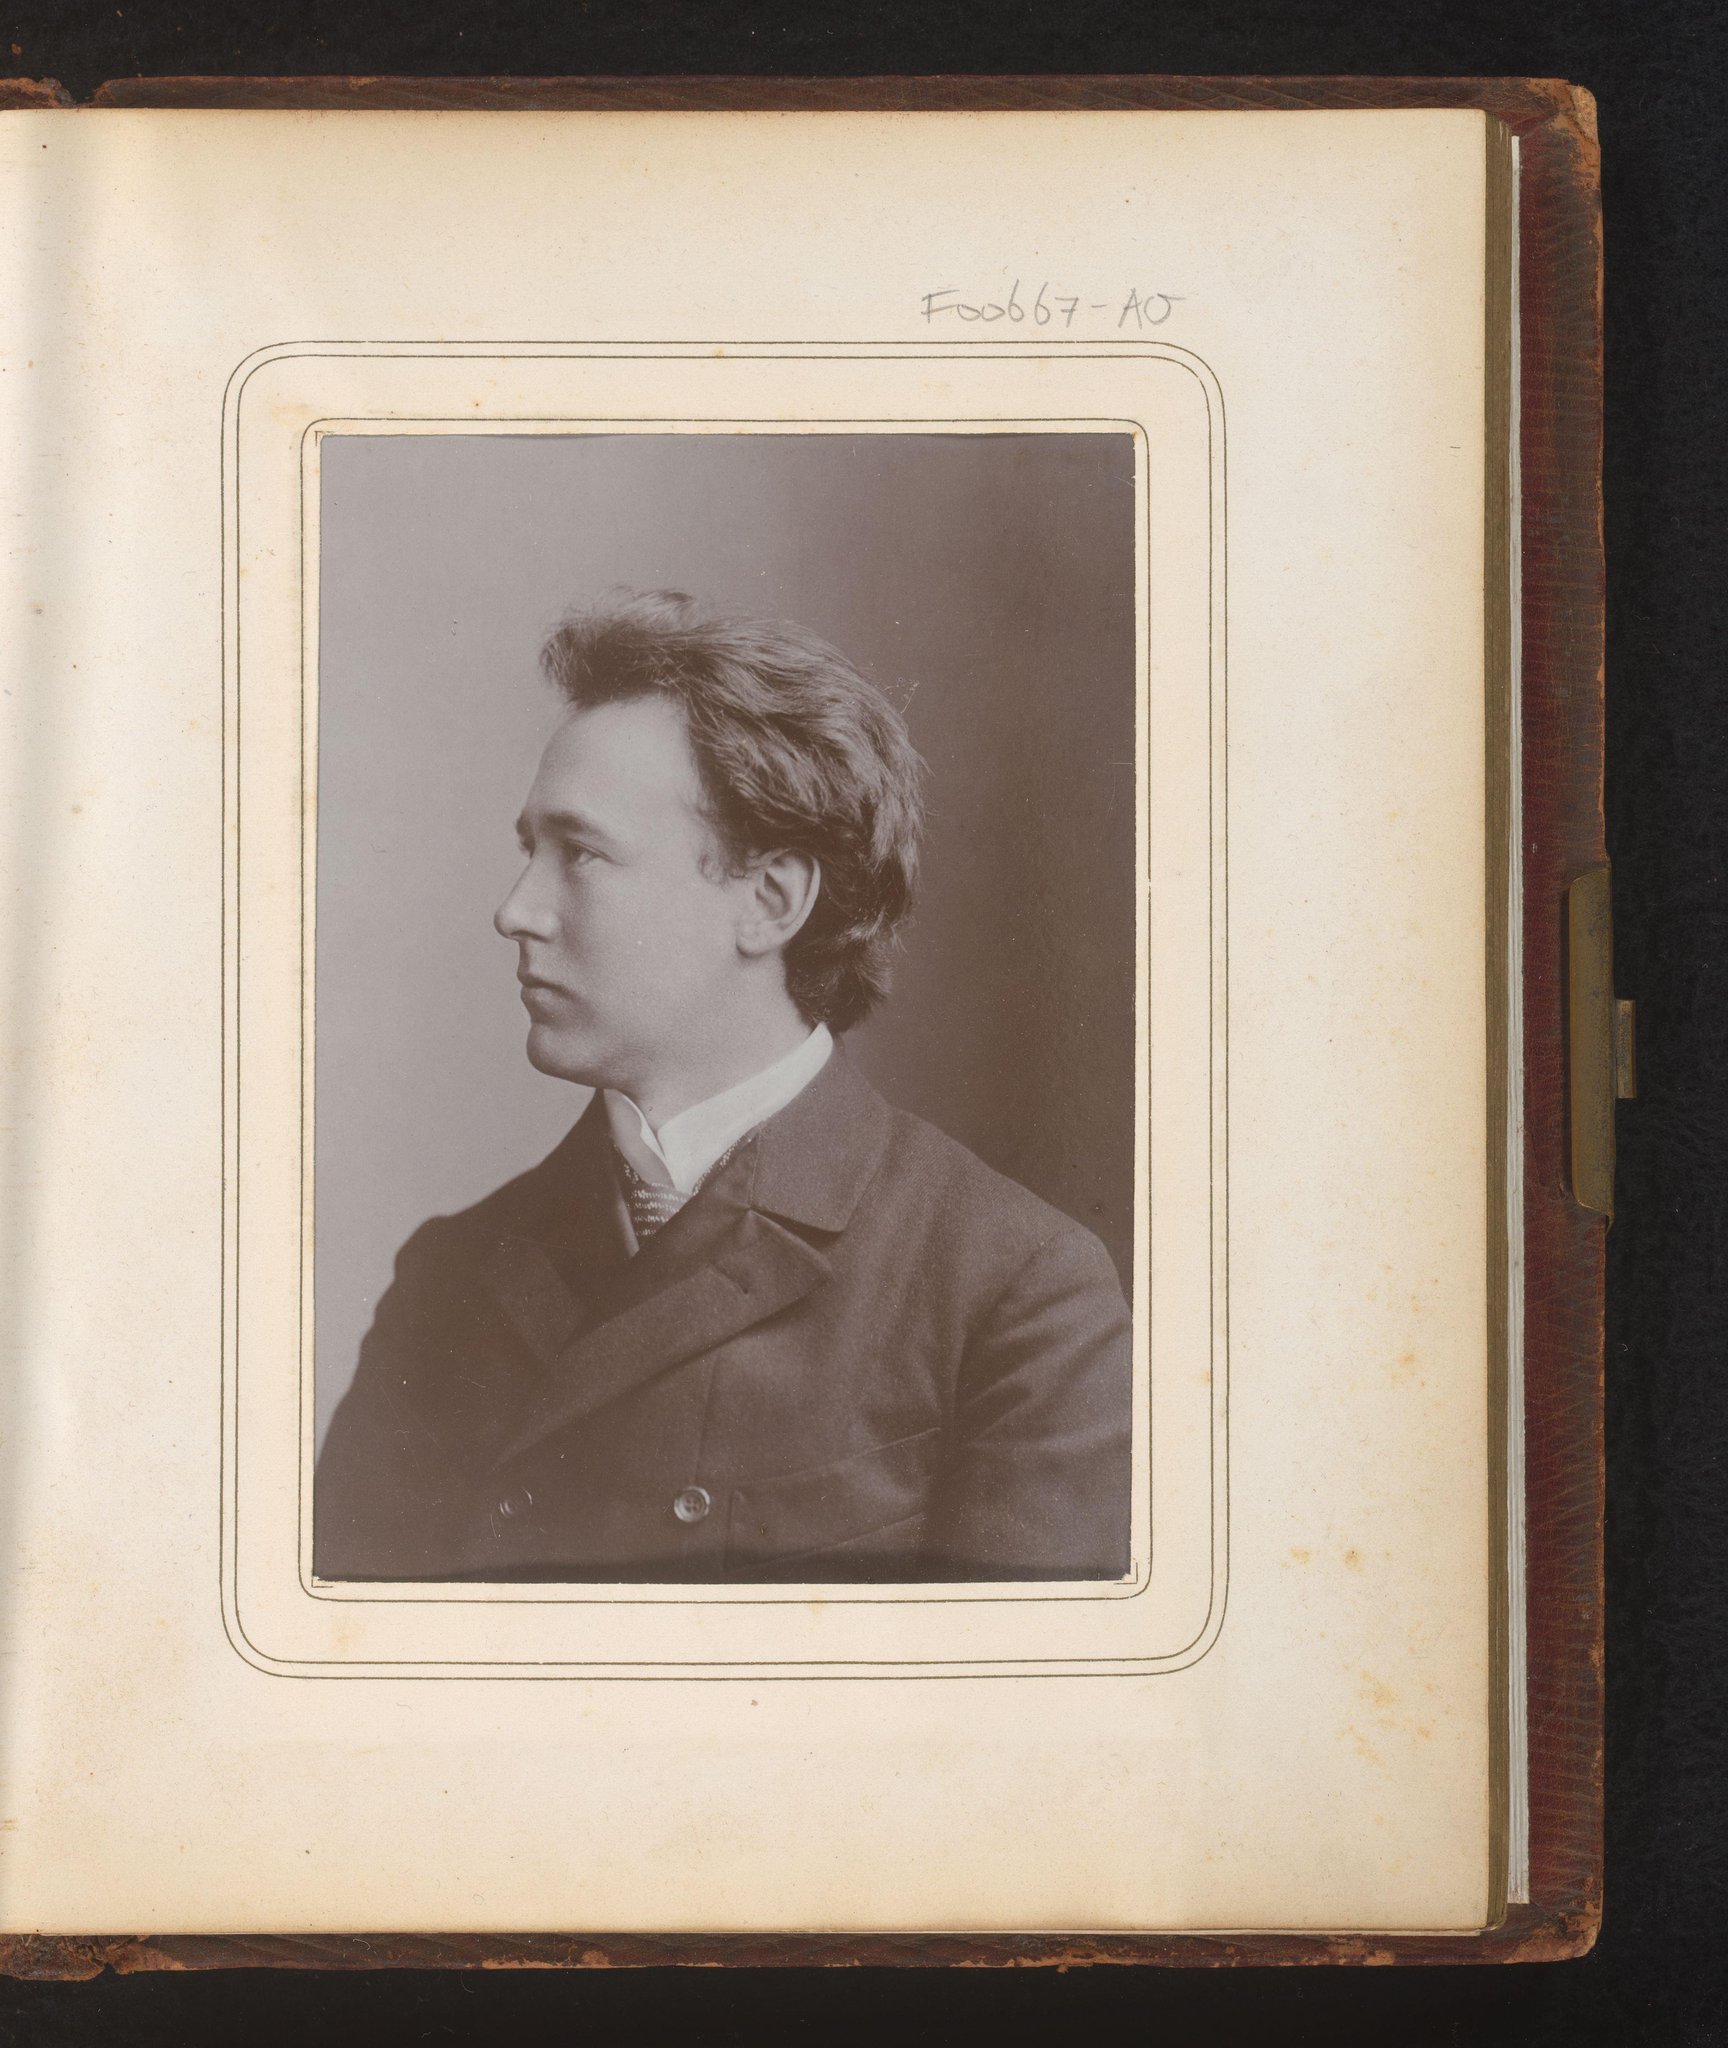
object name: cabinet photograph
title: Portret van een man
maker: h.c. de graaff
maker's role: fotograaf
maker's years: 1853-1932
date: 1890-1910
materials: cardboard, photographic support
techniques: collodion silver print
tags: adult man, historical persons